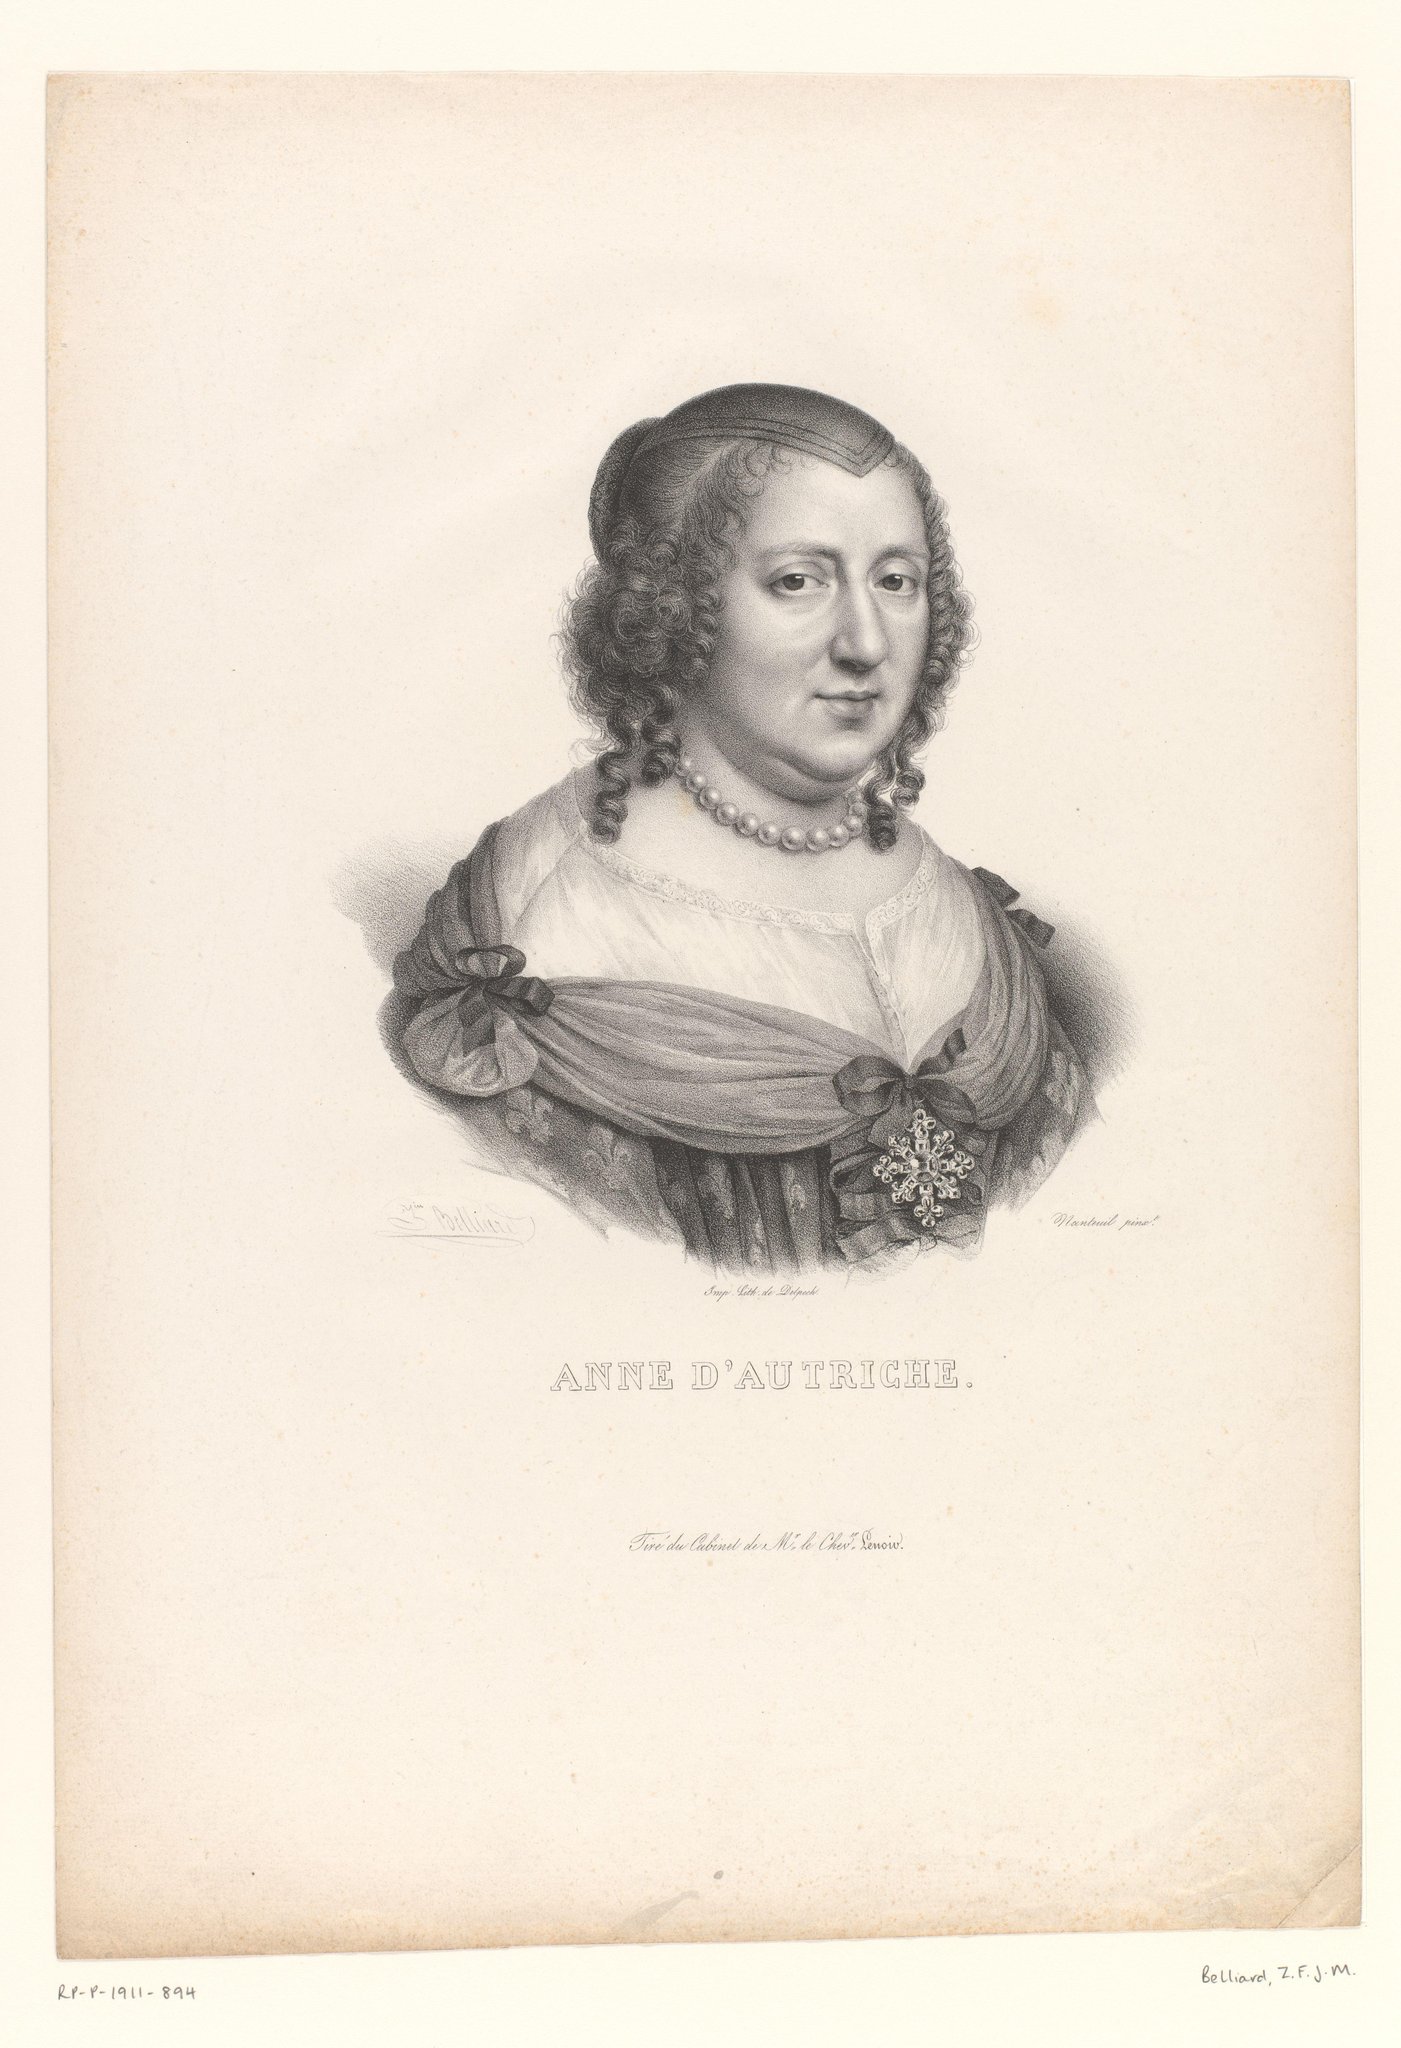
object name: book illustration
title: Tweehonderd portretten tussen de regeringsperioden van Karel VII en Lodewijk XVI van Frankrijk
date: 1828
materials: paper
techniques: lithograph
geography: paris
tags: paris, anna van oostenrijk (koningin van frankrijk), historical persons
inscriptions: collector's mark: Lugt 2228a